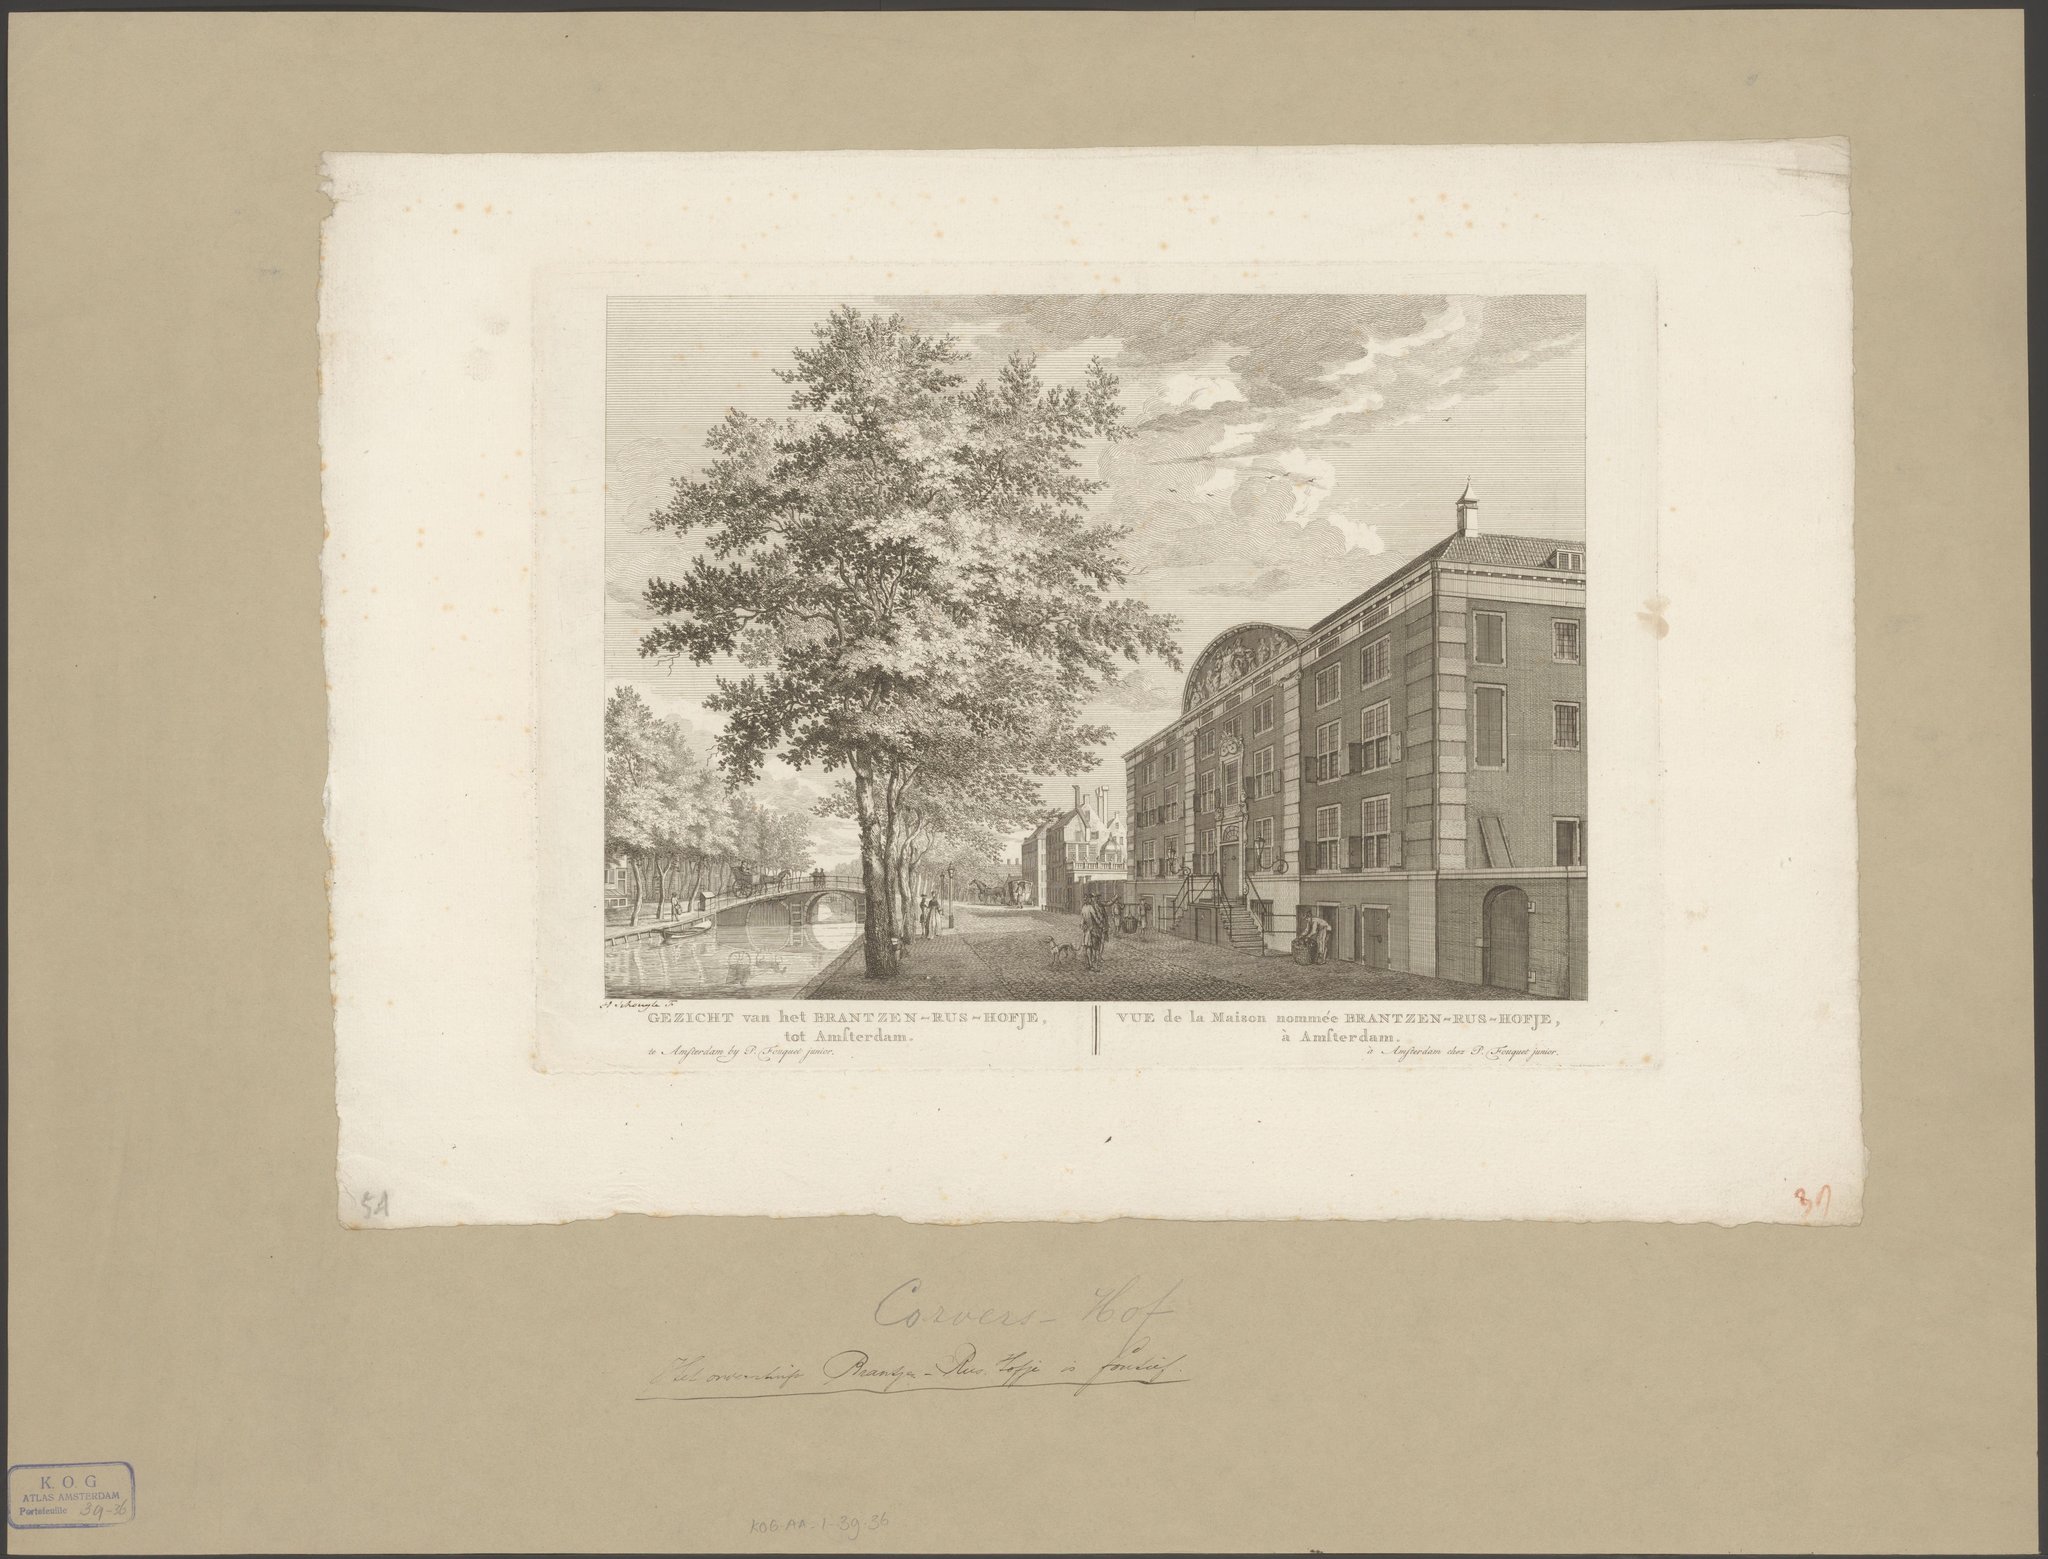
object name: print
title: Gezicht op het Corvershof te Amsterdam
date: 1770-1783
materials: paper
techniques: engraving, etching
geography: amsterdam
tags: alms-house (dutch: 'hofje'), bridge in city across river, canal, etc. (+ city(-scape) with figures, staffage), canals, waters (in city) (+ city(-scape) with figures, staffage), street (+ city(-scape) with figures, staffage)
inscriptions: collector's mark: Lugt 1641b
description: Vanaf 1760 gaf Pierre Fouquet stadsgezichten van Amsterdam naar tekeningen van verschillende kunstenaars uit. Deze prenten werden aanvankelijk los verkocht. Later werden ze samengebonden verkocht in verschillende volgordes en aantallen in: (1). Afbeeldingen van de wyd-vermaarde koopstad Amsterdam benevens des zelvs voornaamste gebouwen en gezigten alle naar het leeven getekend / Receuil des edifices les plus considerables et des plus belles vues, de la fameuse ville d'Amsterdam, dessinées d'après nature. Amsterdam: Pierre Fouquet, 1778-1783. Deze 'uitgave' bestond waarschijnlijk alleen uit een titelblad en inhoudsopgave van de tot dusver 100 uitgegeven prenten, die de koper zelf aan zijn of haar reeds verzamelde prenten kon toevoegen. De hoeveelheid en volgorde van prenten verzameld onder deze titel verschilt dus sterk. (2). Nieuwe atlas, van de voornaamste gebouwen en gezigten der stad Amsterdam, met derzelver beknopte beschryvingen. 2 dln. Amsterdam: Daniël Jean Changuion en Petrus den Hengst [in opdracht van Pierre Fouquet], 1783. Ook werden er door verschillende uitgevers tussen 1788 (Amsterdam: Petrus Conradi) en 1805 (Amsterdam: Evert Maaskamp) heruitgaven gepubliceerd.